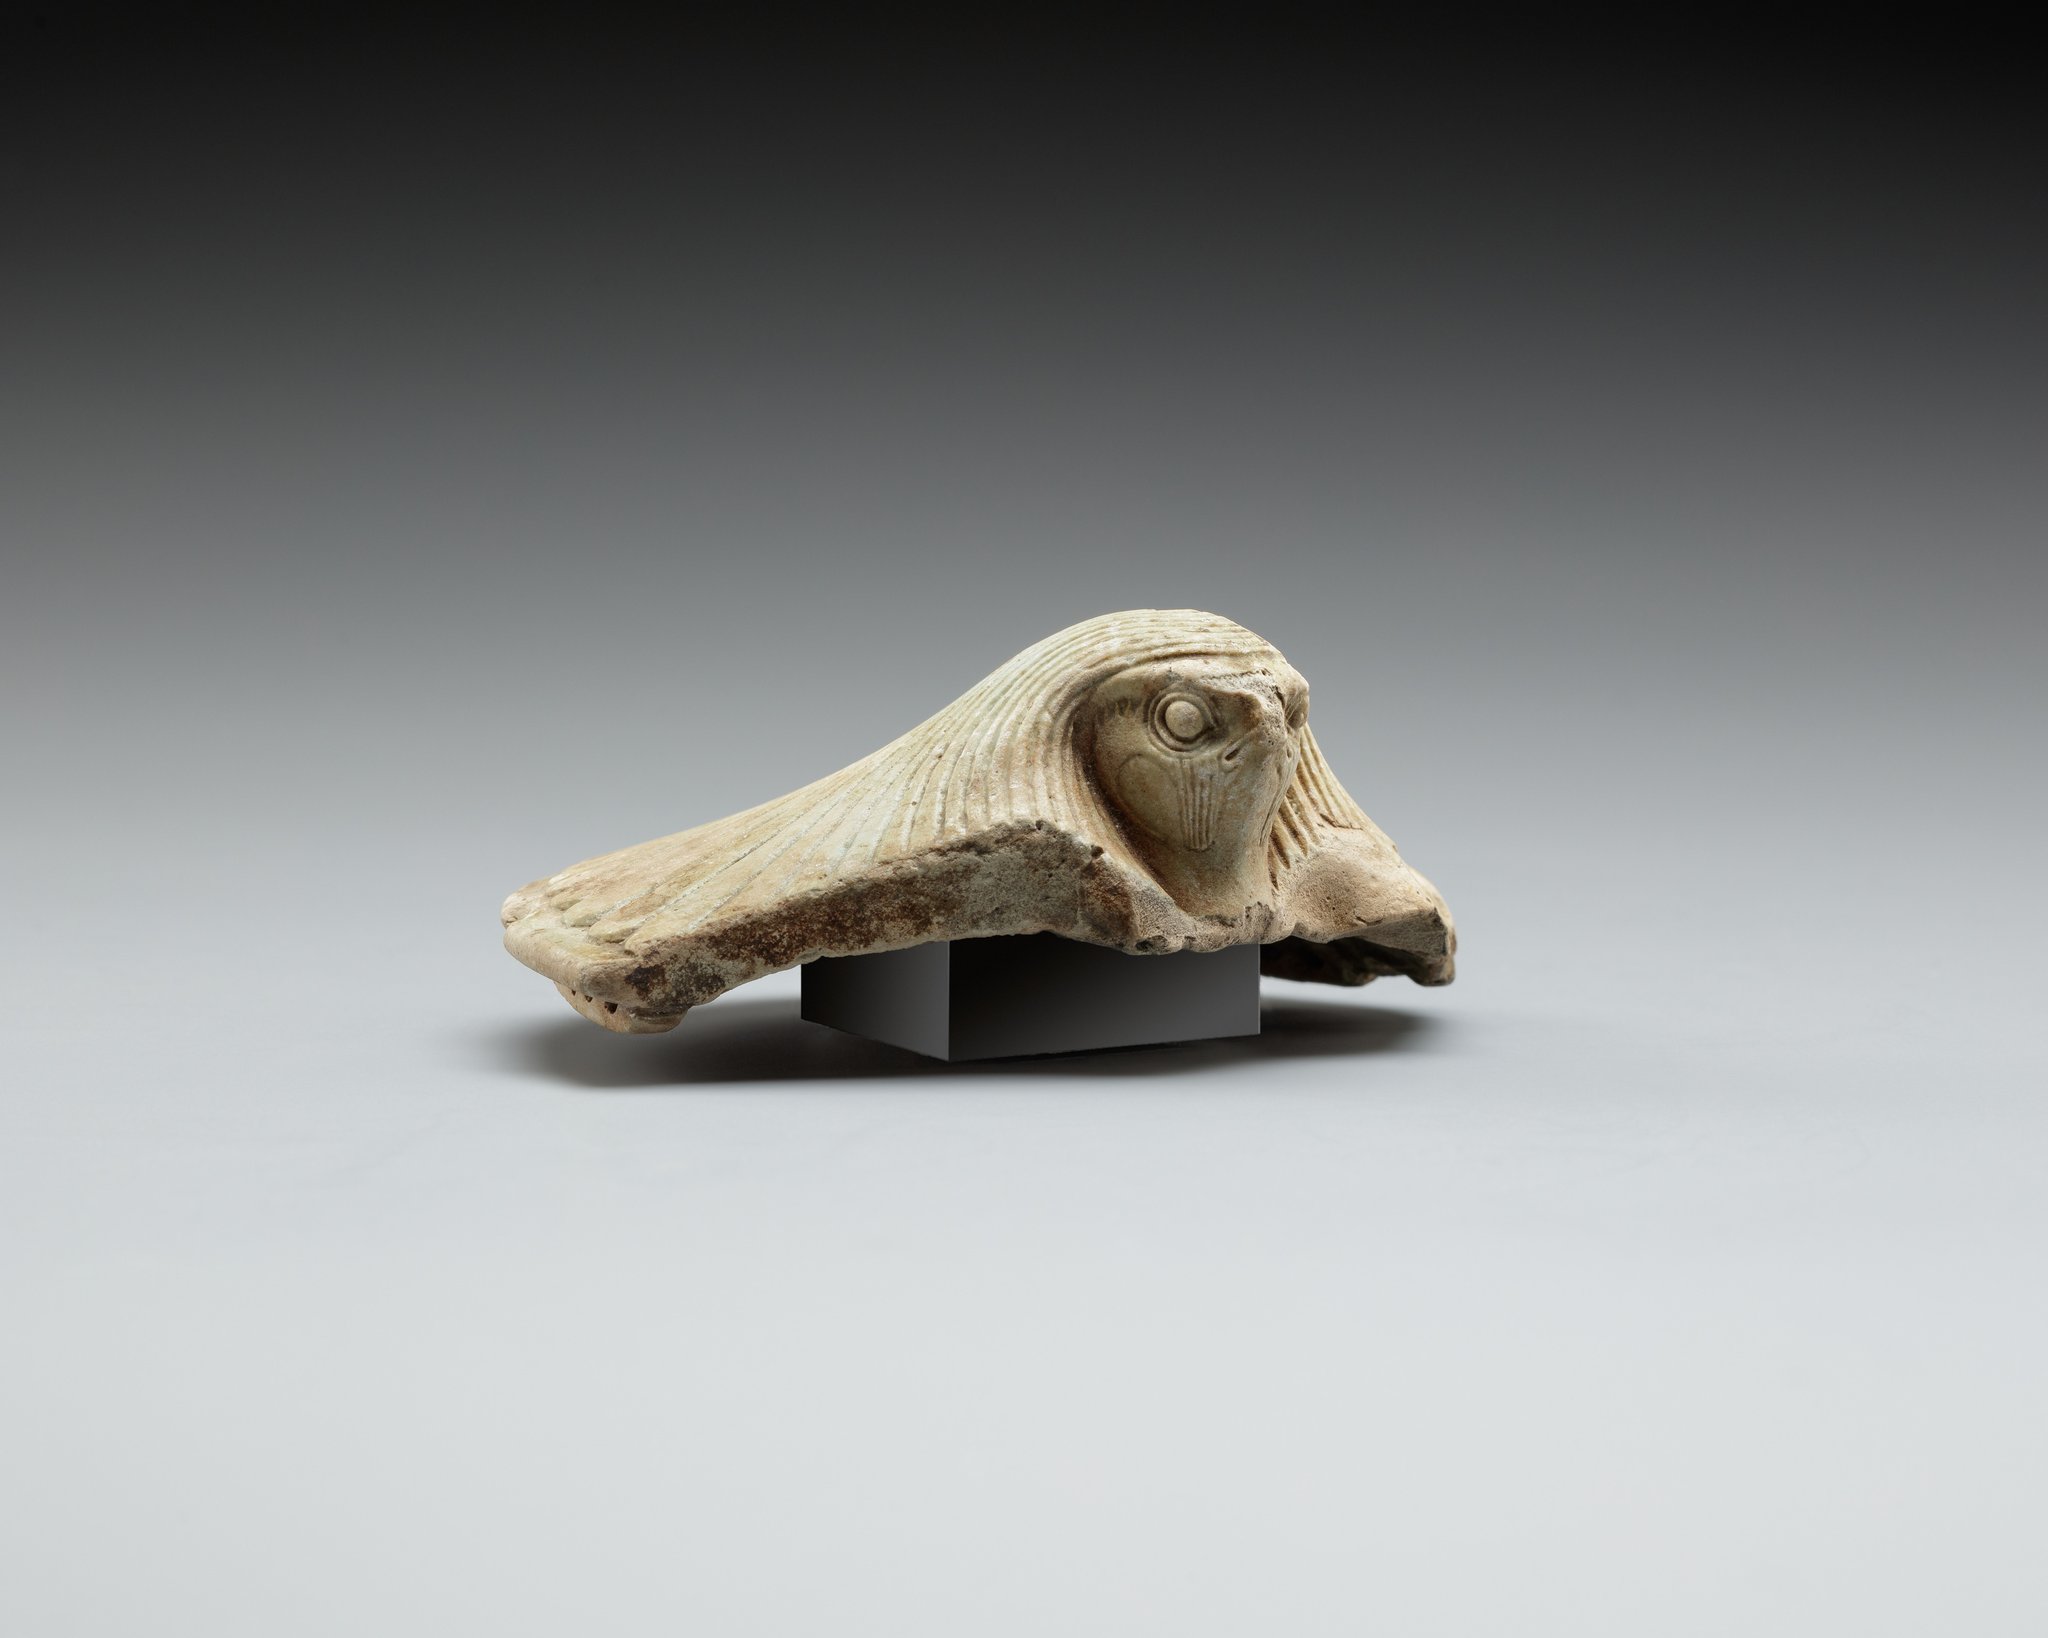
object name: lid fragment, falcon head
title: Lid fragment in form of a falcon's head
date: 664-332 BCE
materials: faience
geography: egypt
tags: falcons